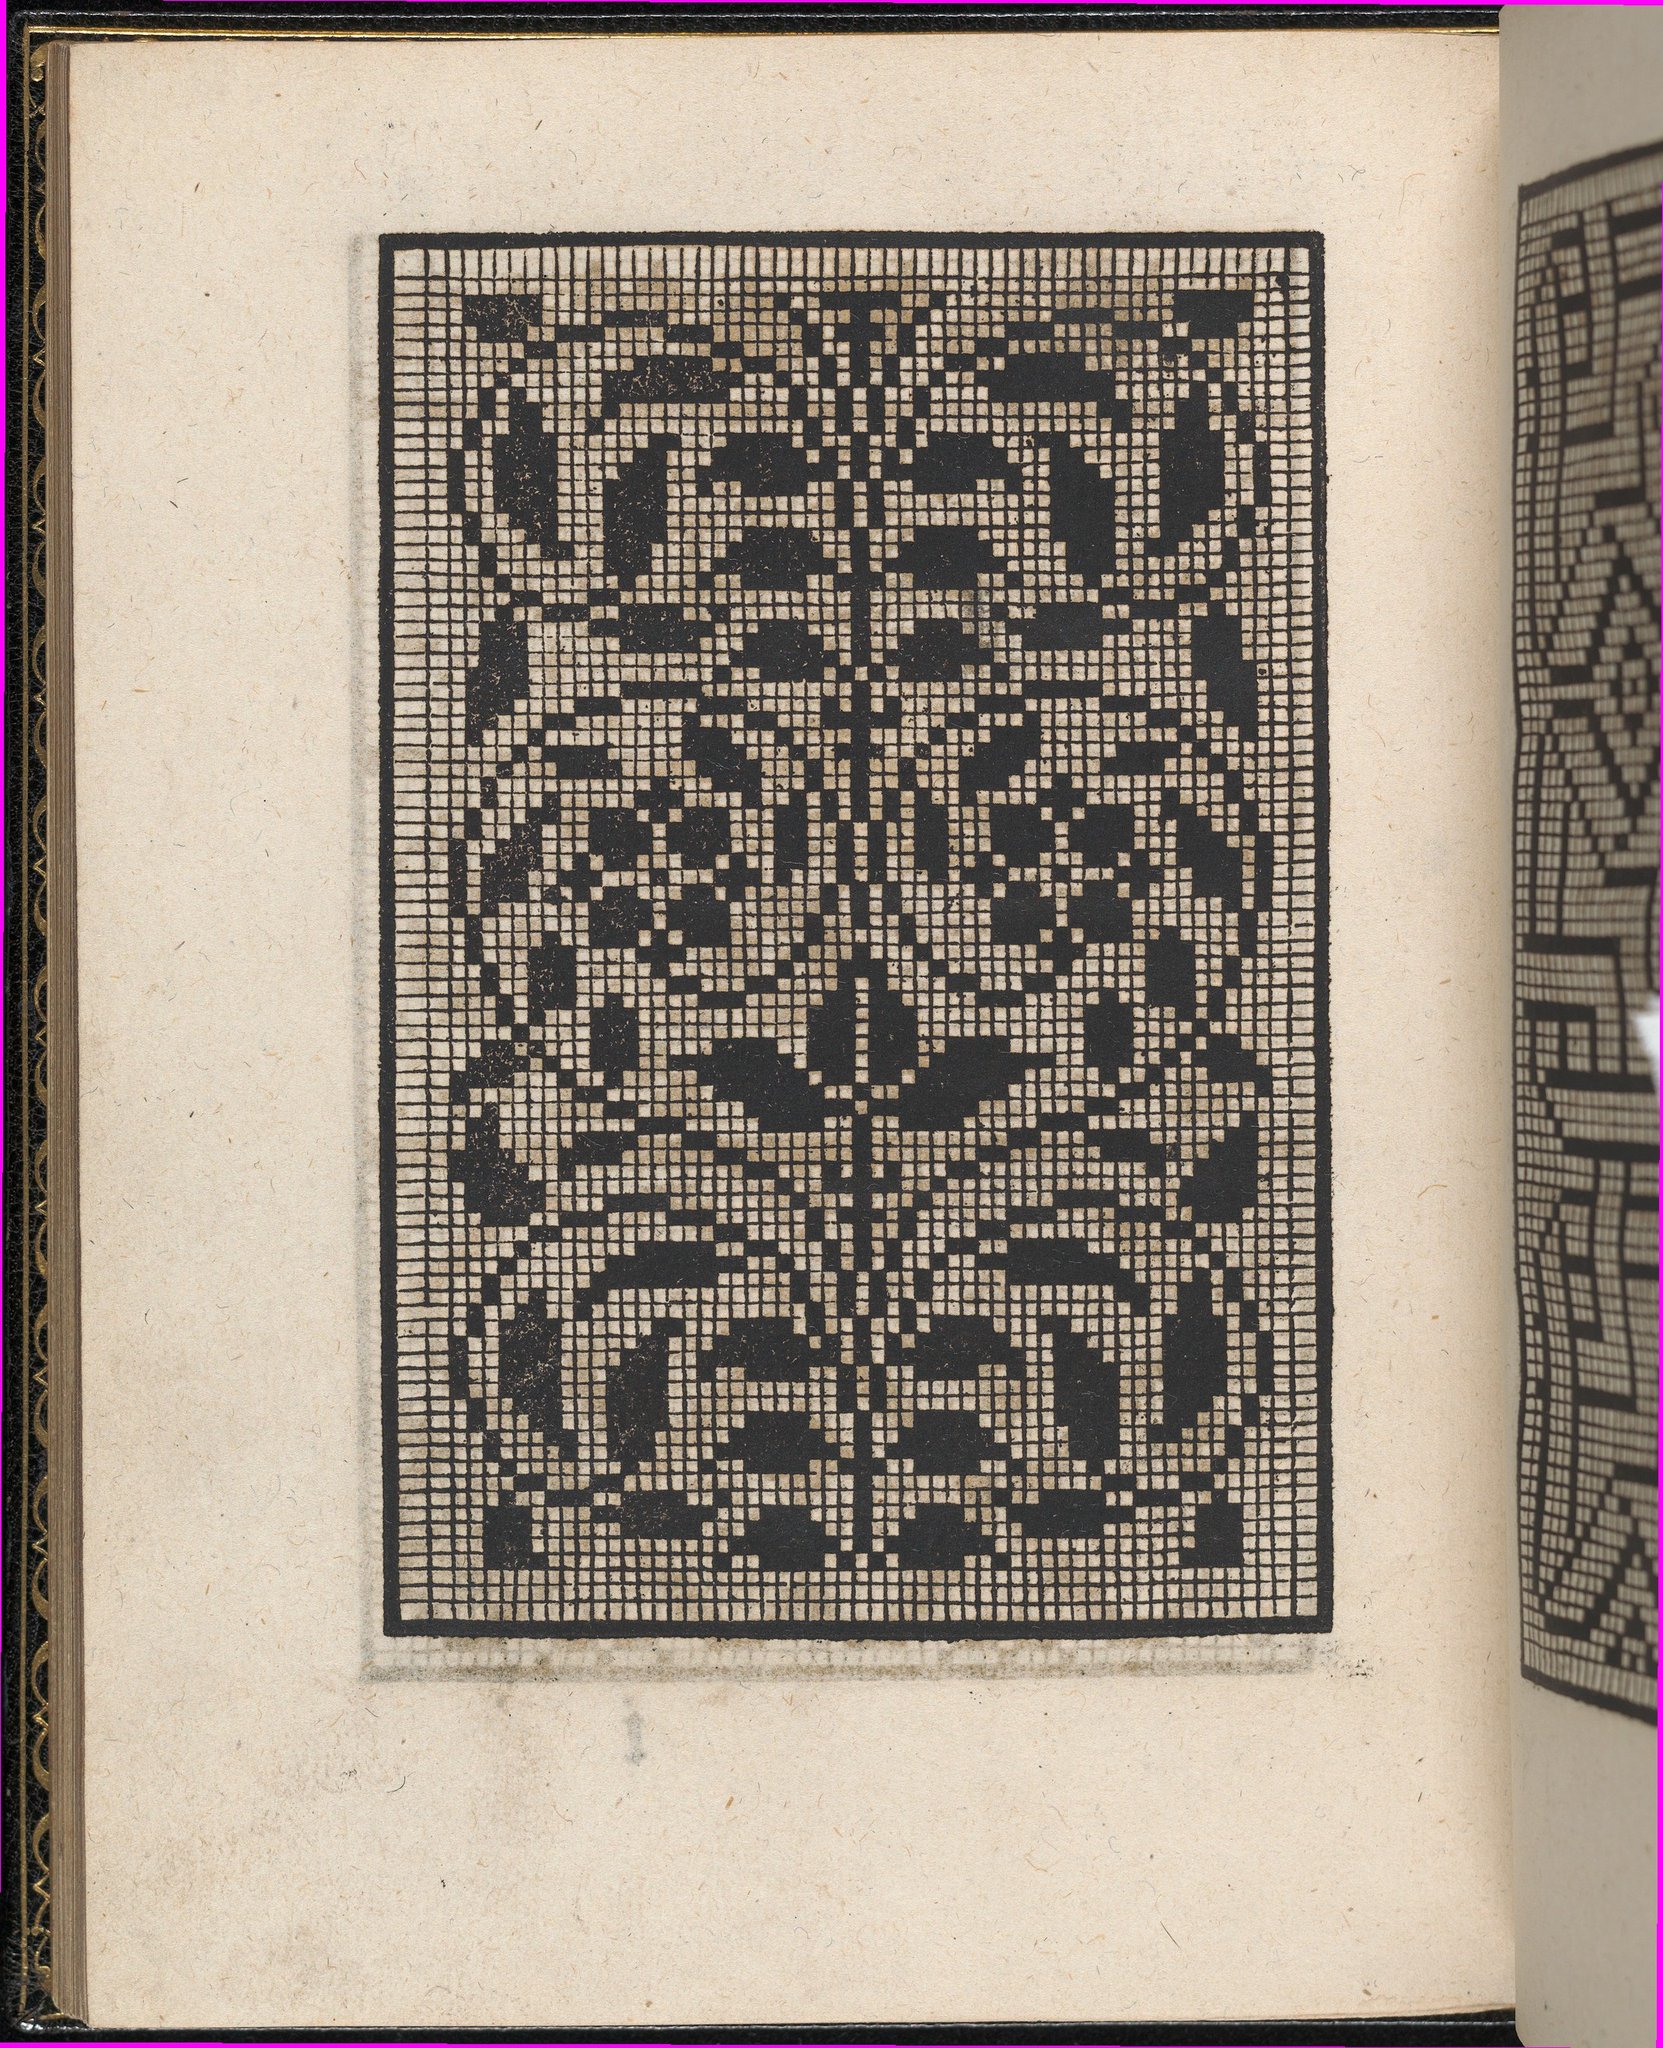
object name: book print ornament architecture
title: Page from Ein new kunstlich Modelbuch...(Page 40v)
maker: peter quentel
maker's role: publisher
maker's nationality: german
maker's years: 1500-1550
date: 1544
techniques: woodcut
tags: flowers